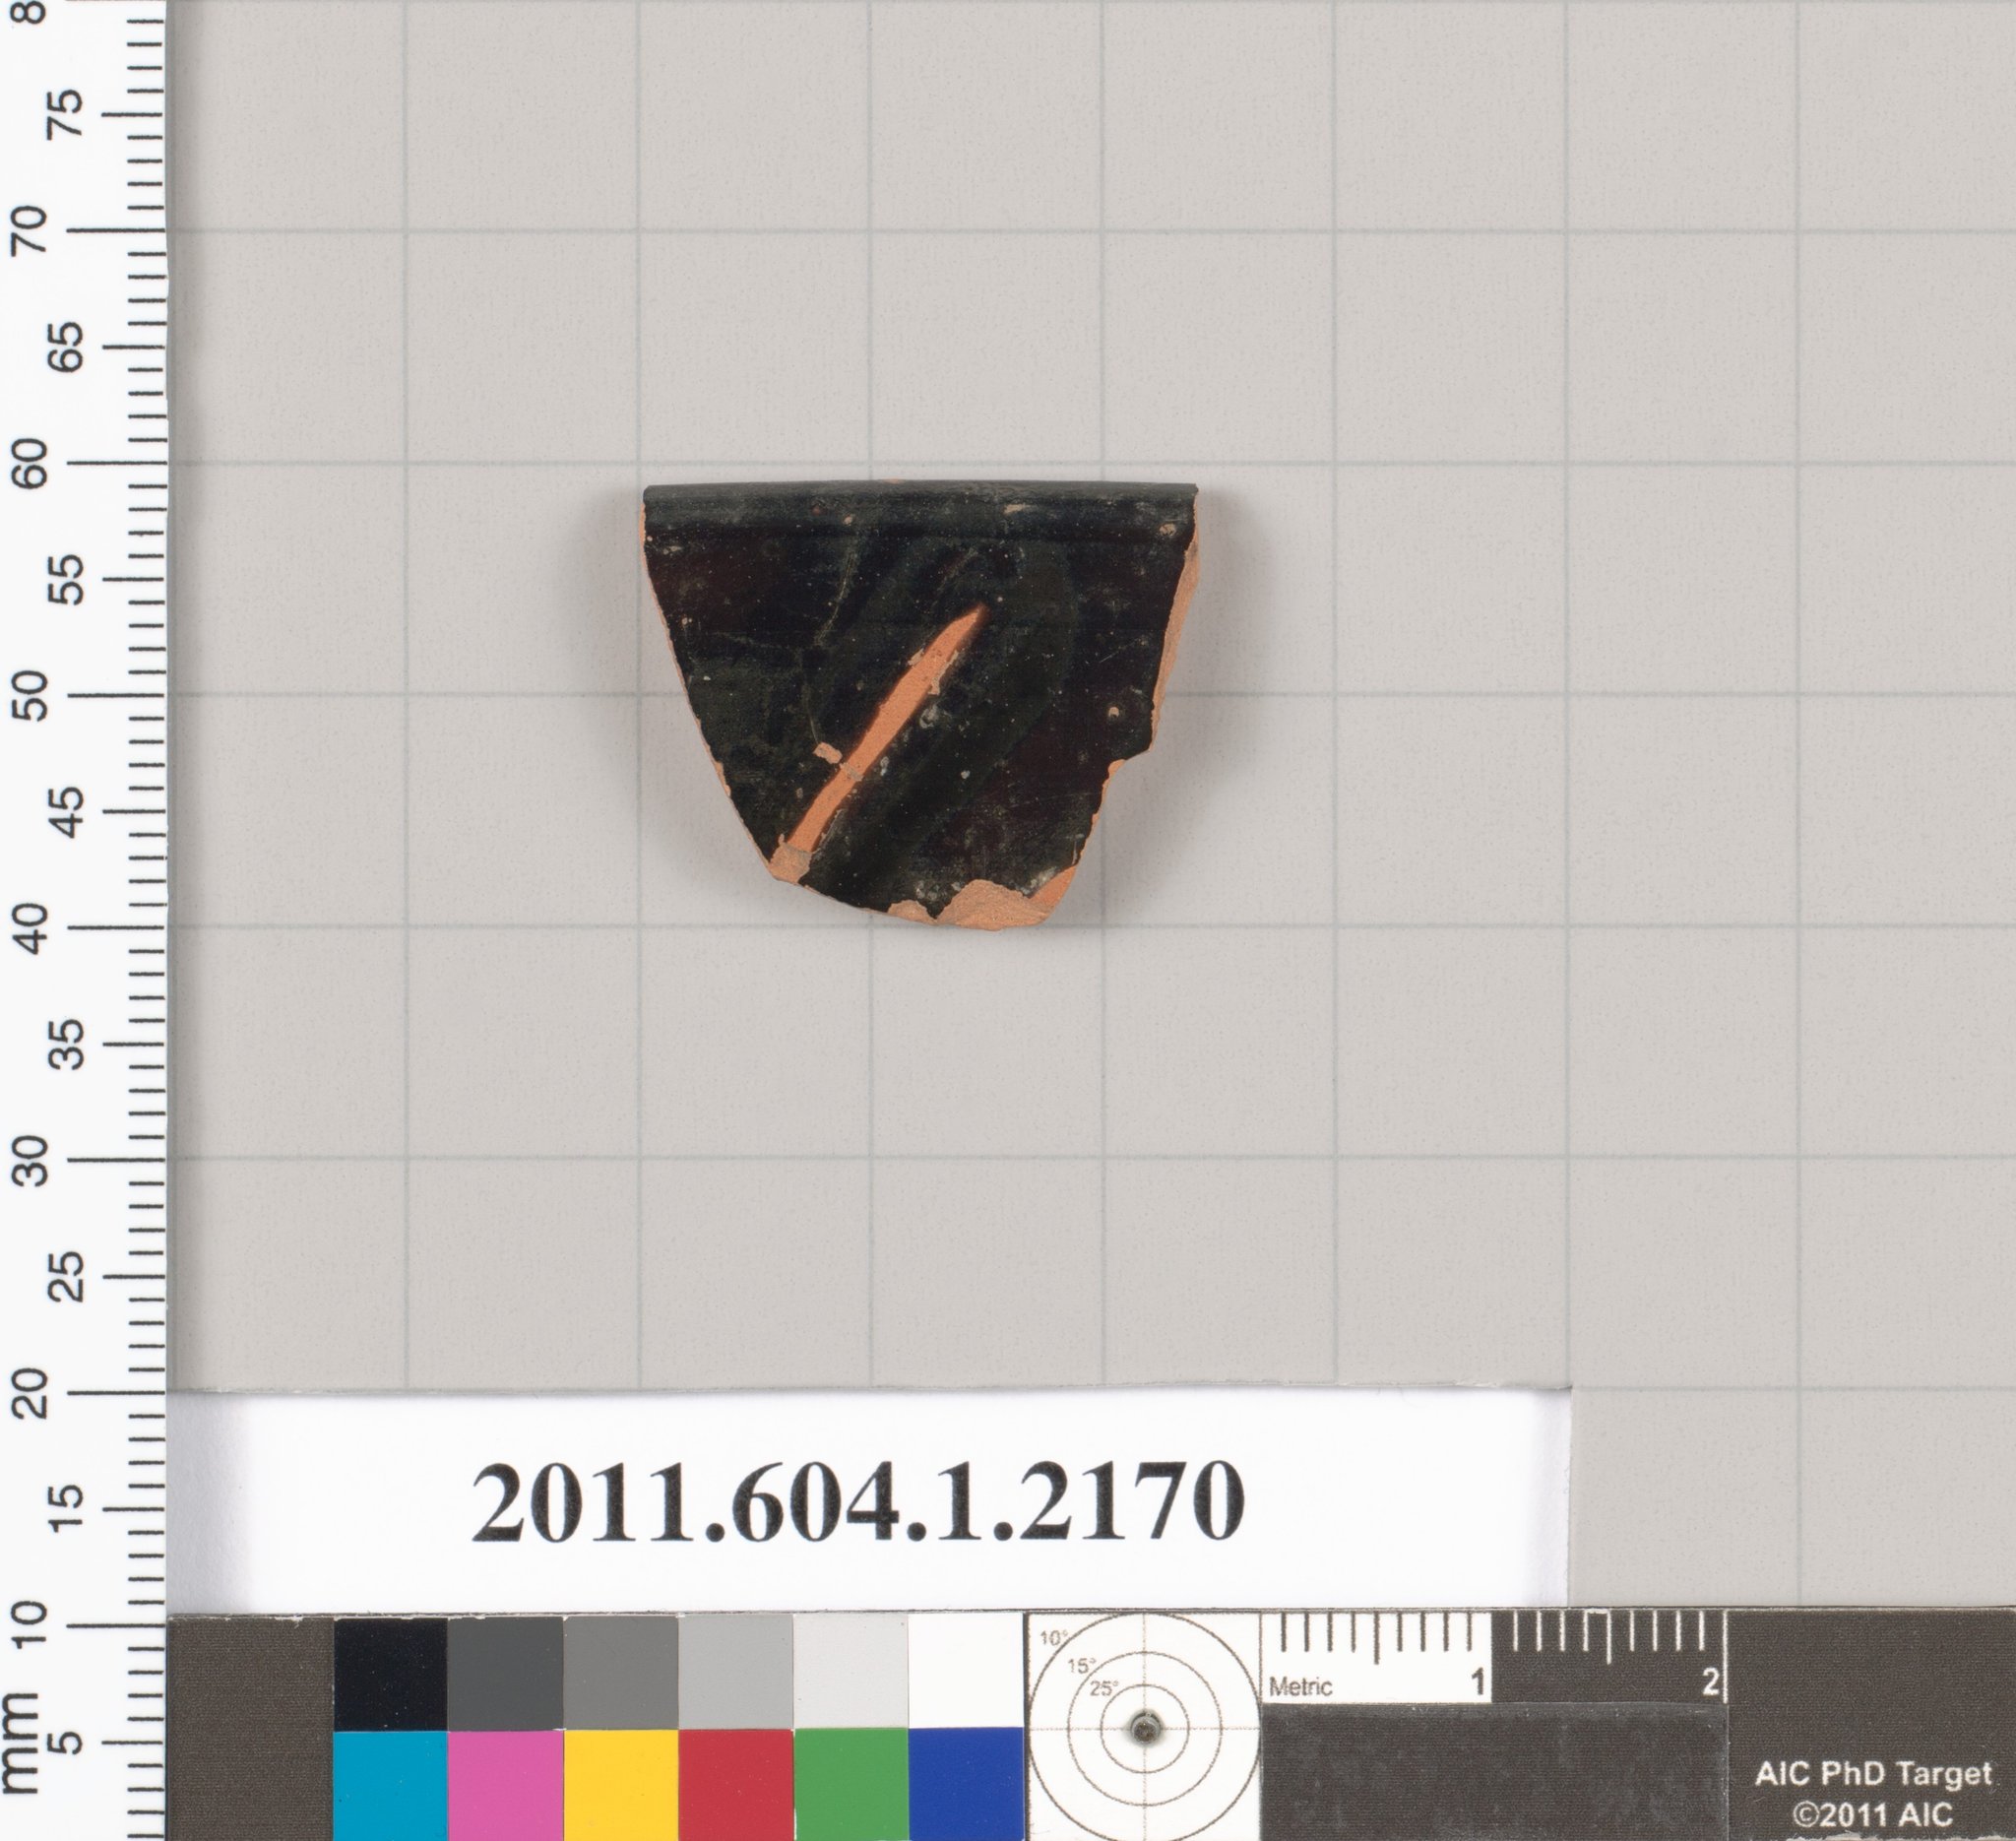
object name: kylix fragment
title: Terracotta rim fragment of a kylix (drinking cup)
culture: greek, attic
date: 500-401 BCE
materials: terracotta